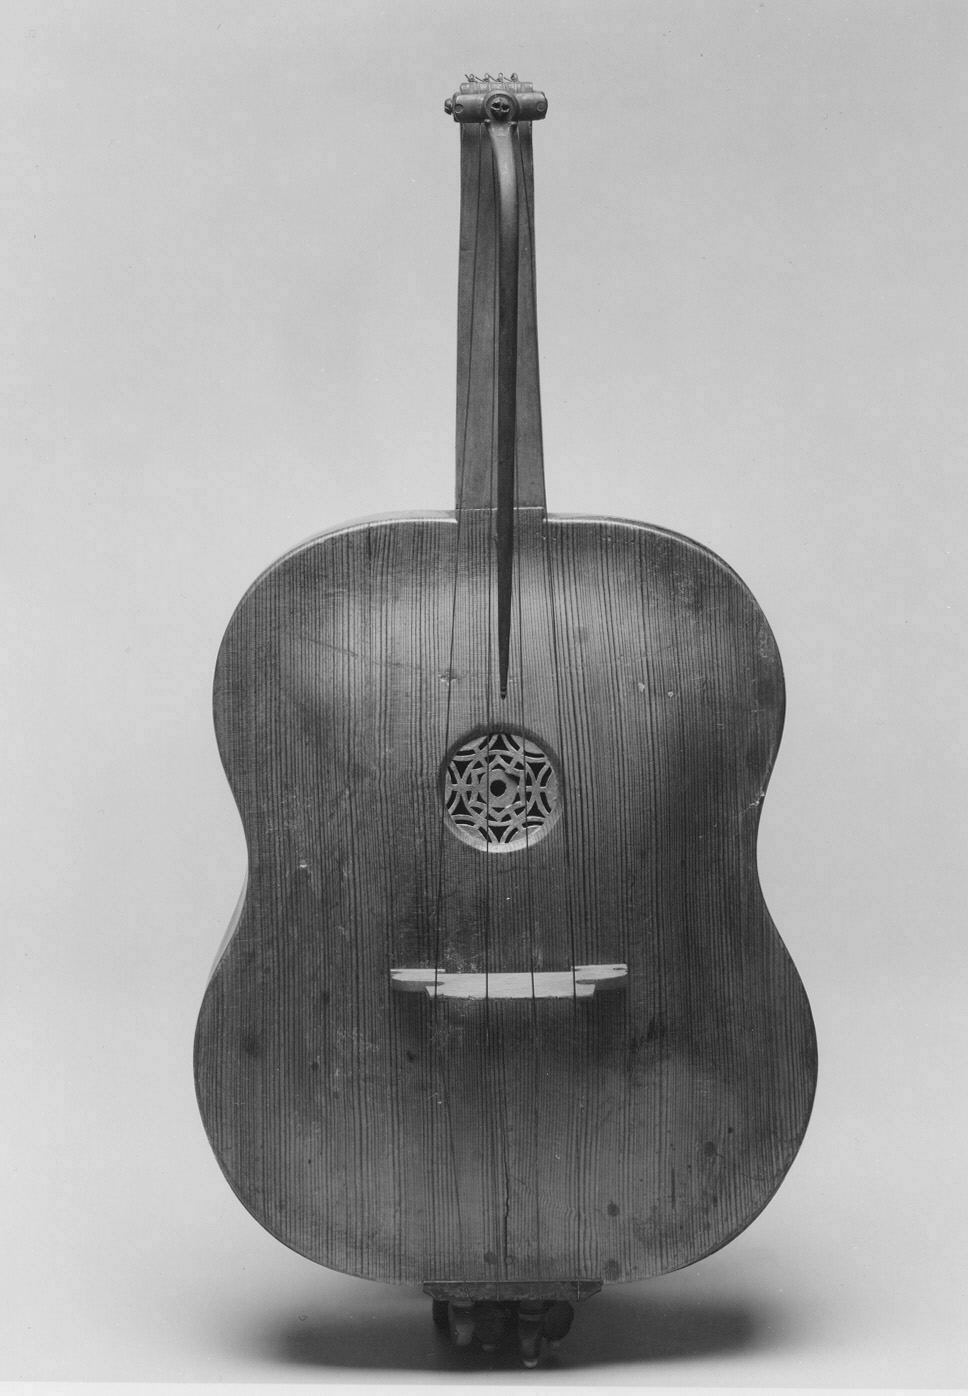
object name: cither viol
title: Cither-Viol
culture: spanish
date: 1801-1833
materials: wood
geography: spain